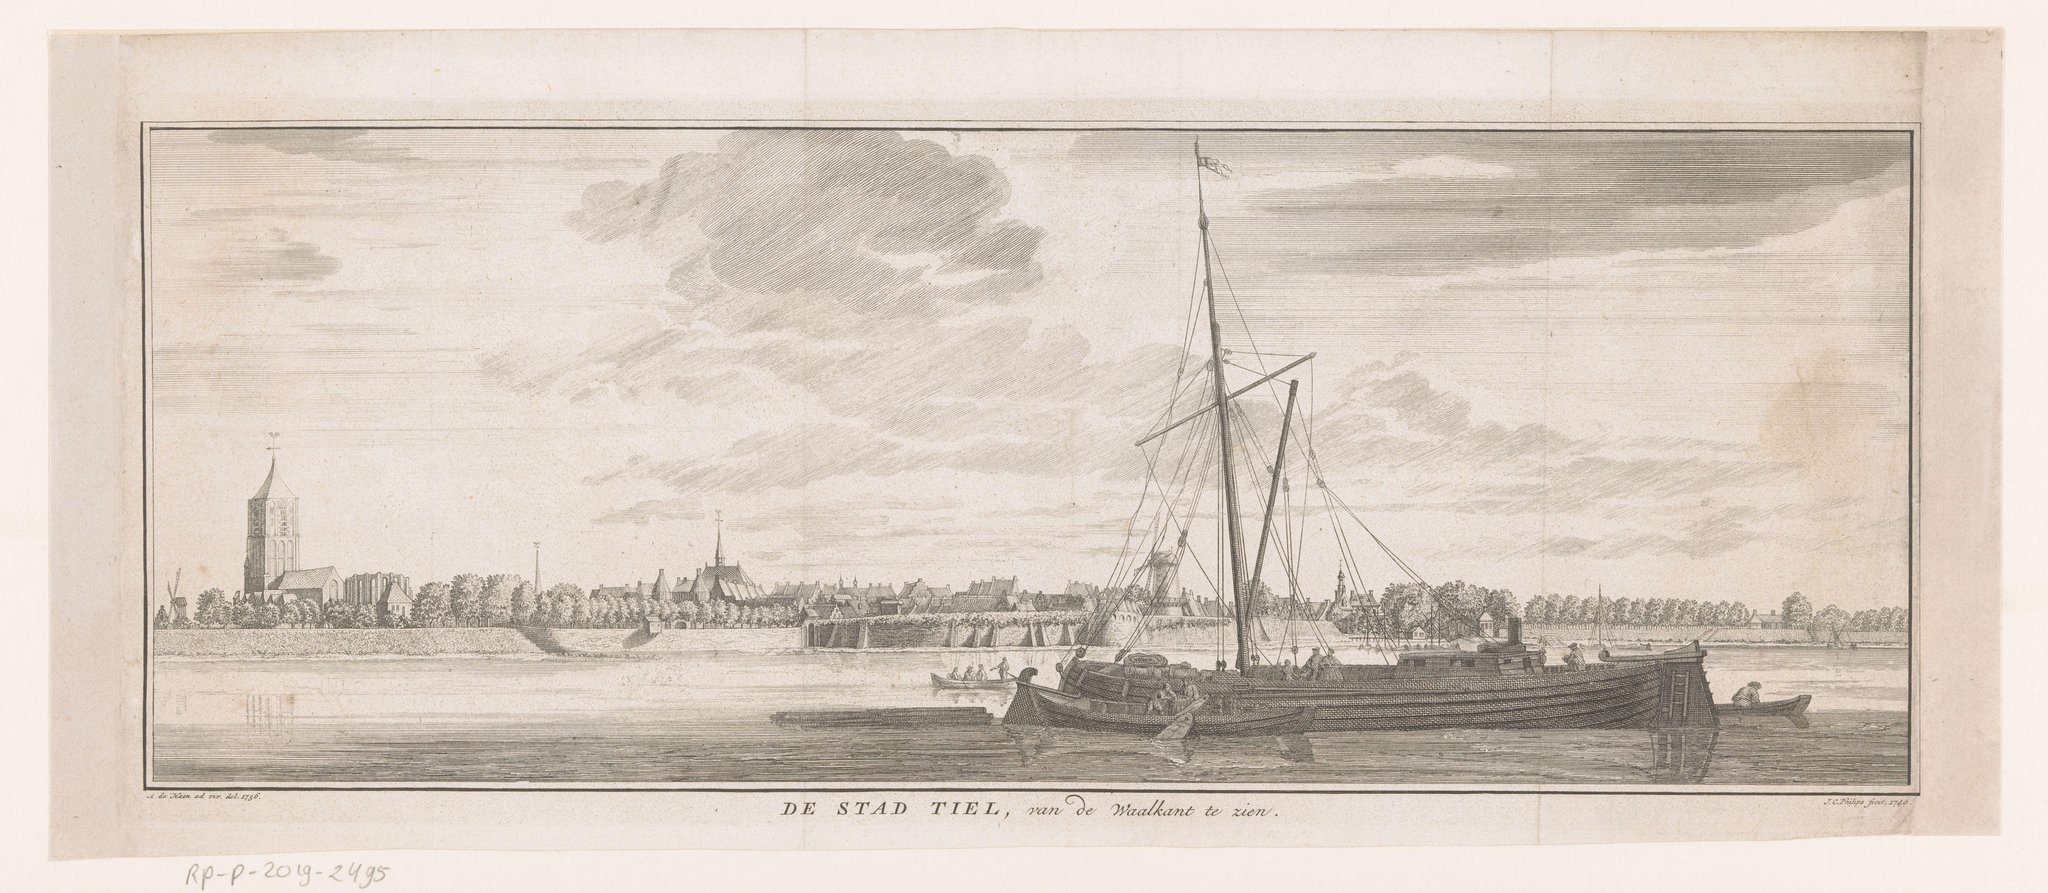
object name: book illustration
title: Gezicht op Tiel vanaf de Waal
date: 1740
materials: paper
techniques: etching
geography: amsterdam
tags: river (+ landscape with figures, staffage), prospect of city, town panorama, silhouette of city (+ city(-scape) with figures, staffage)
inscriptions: date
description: Prent uit: Wagenaar, Jan. Tegenwoordige staat der Vereenigde Nederlanden (...). Amsterdam: Isaak Tirion, 1741, dl. 3.